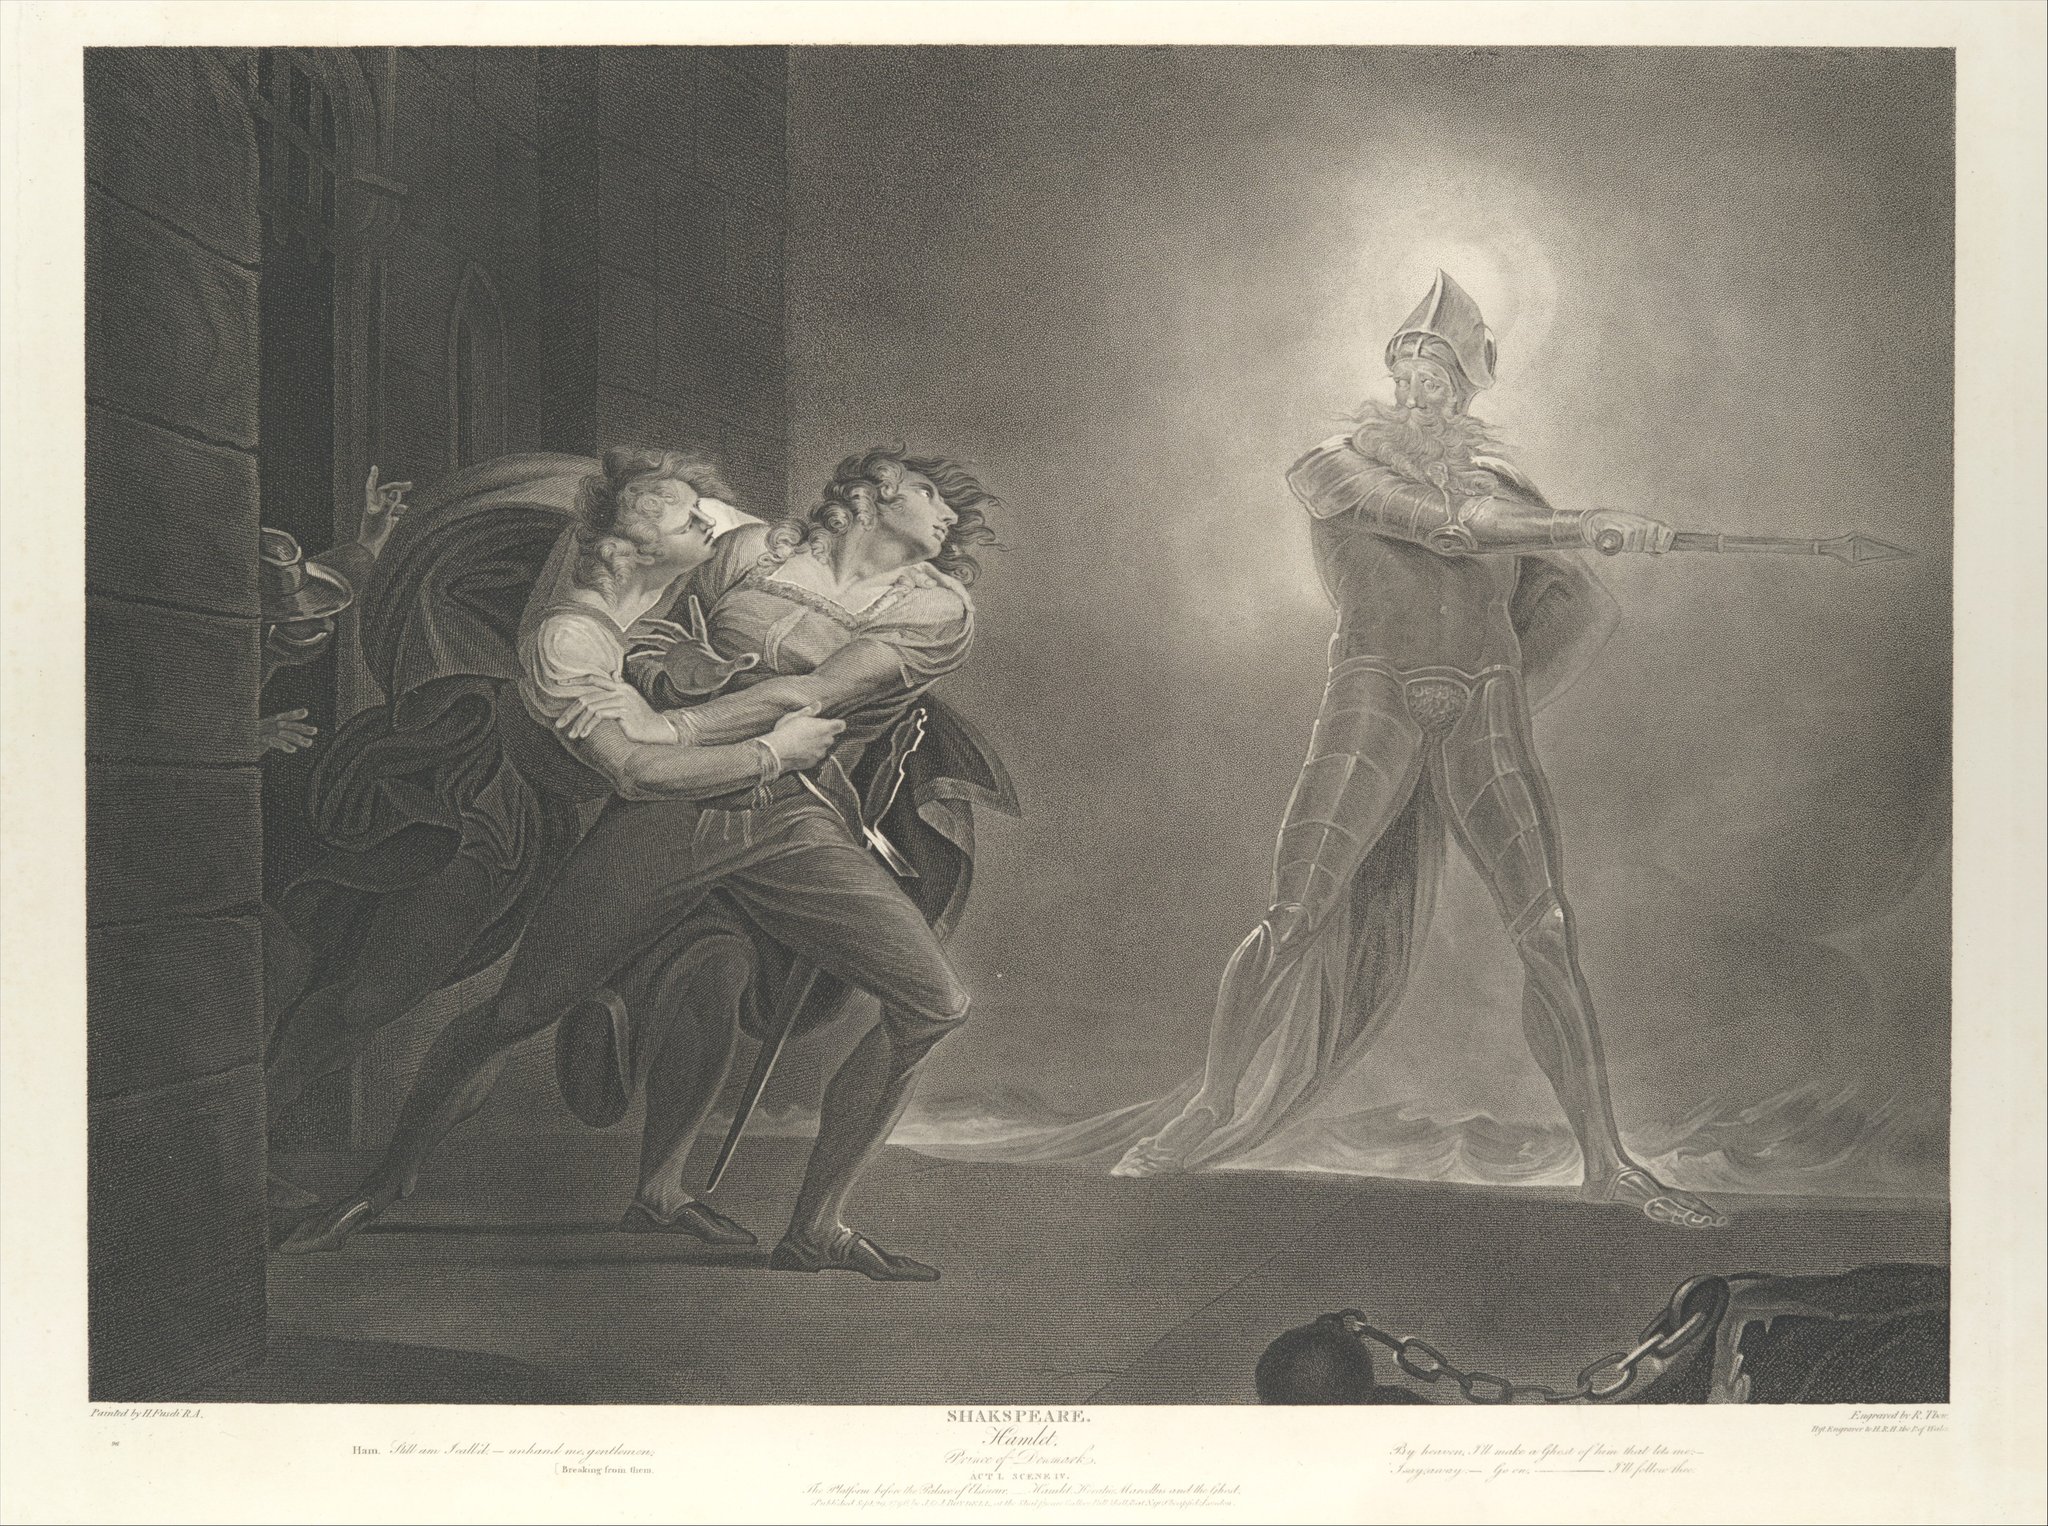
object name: print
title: Hamlet, Horatio, Marcellus and the Ghost (Shakespeare, Hamlet, Act 1, Scene 4)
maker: robert thew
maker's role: engraver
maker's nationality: british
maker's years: 1758-1802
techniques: engraving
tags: shakespeare,men,hamlet